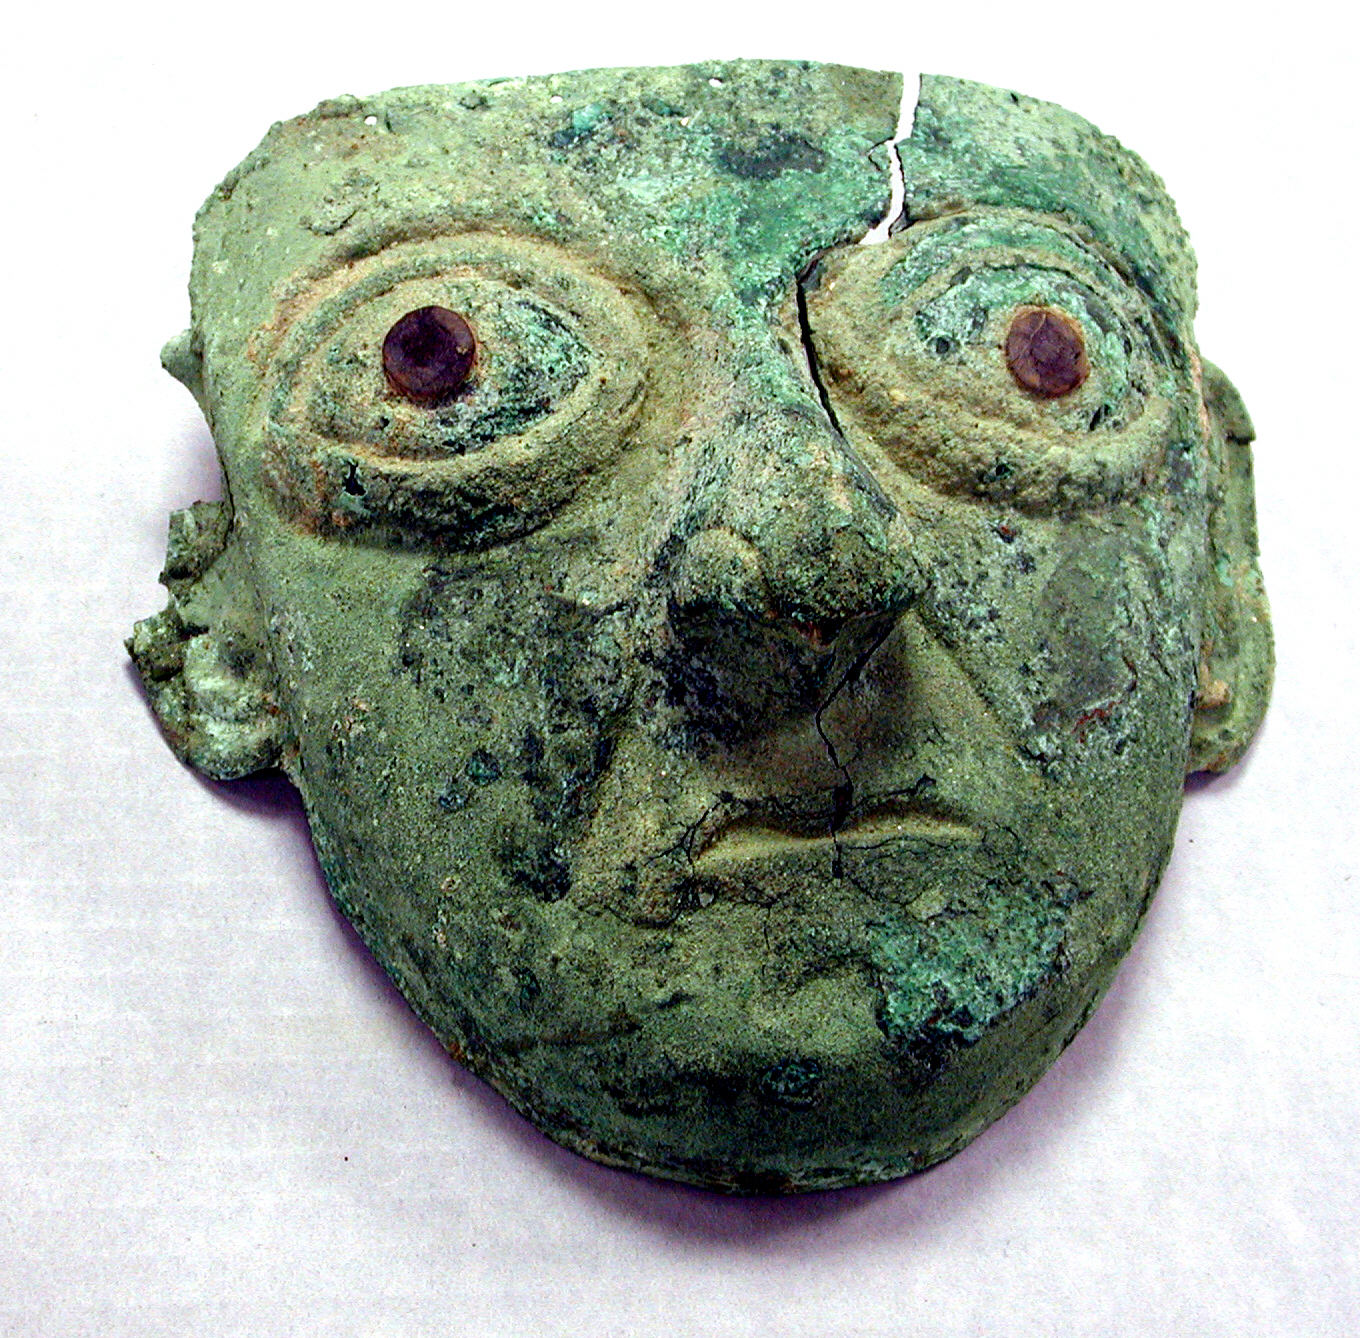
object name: ornament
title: Copper Face Mask Ornament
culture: moche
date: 101-700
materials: copper, shell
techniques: hammering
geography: peru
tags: faces